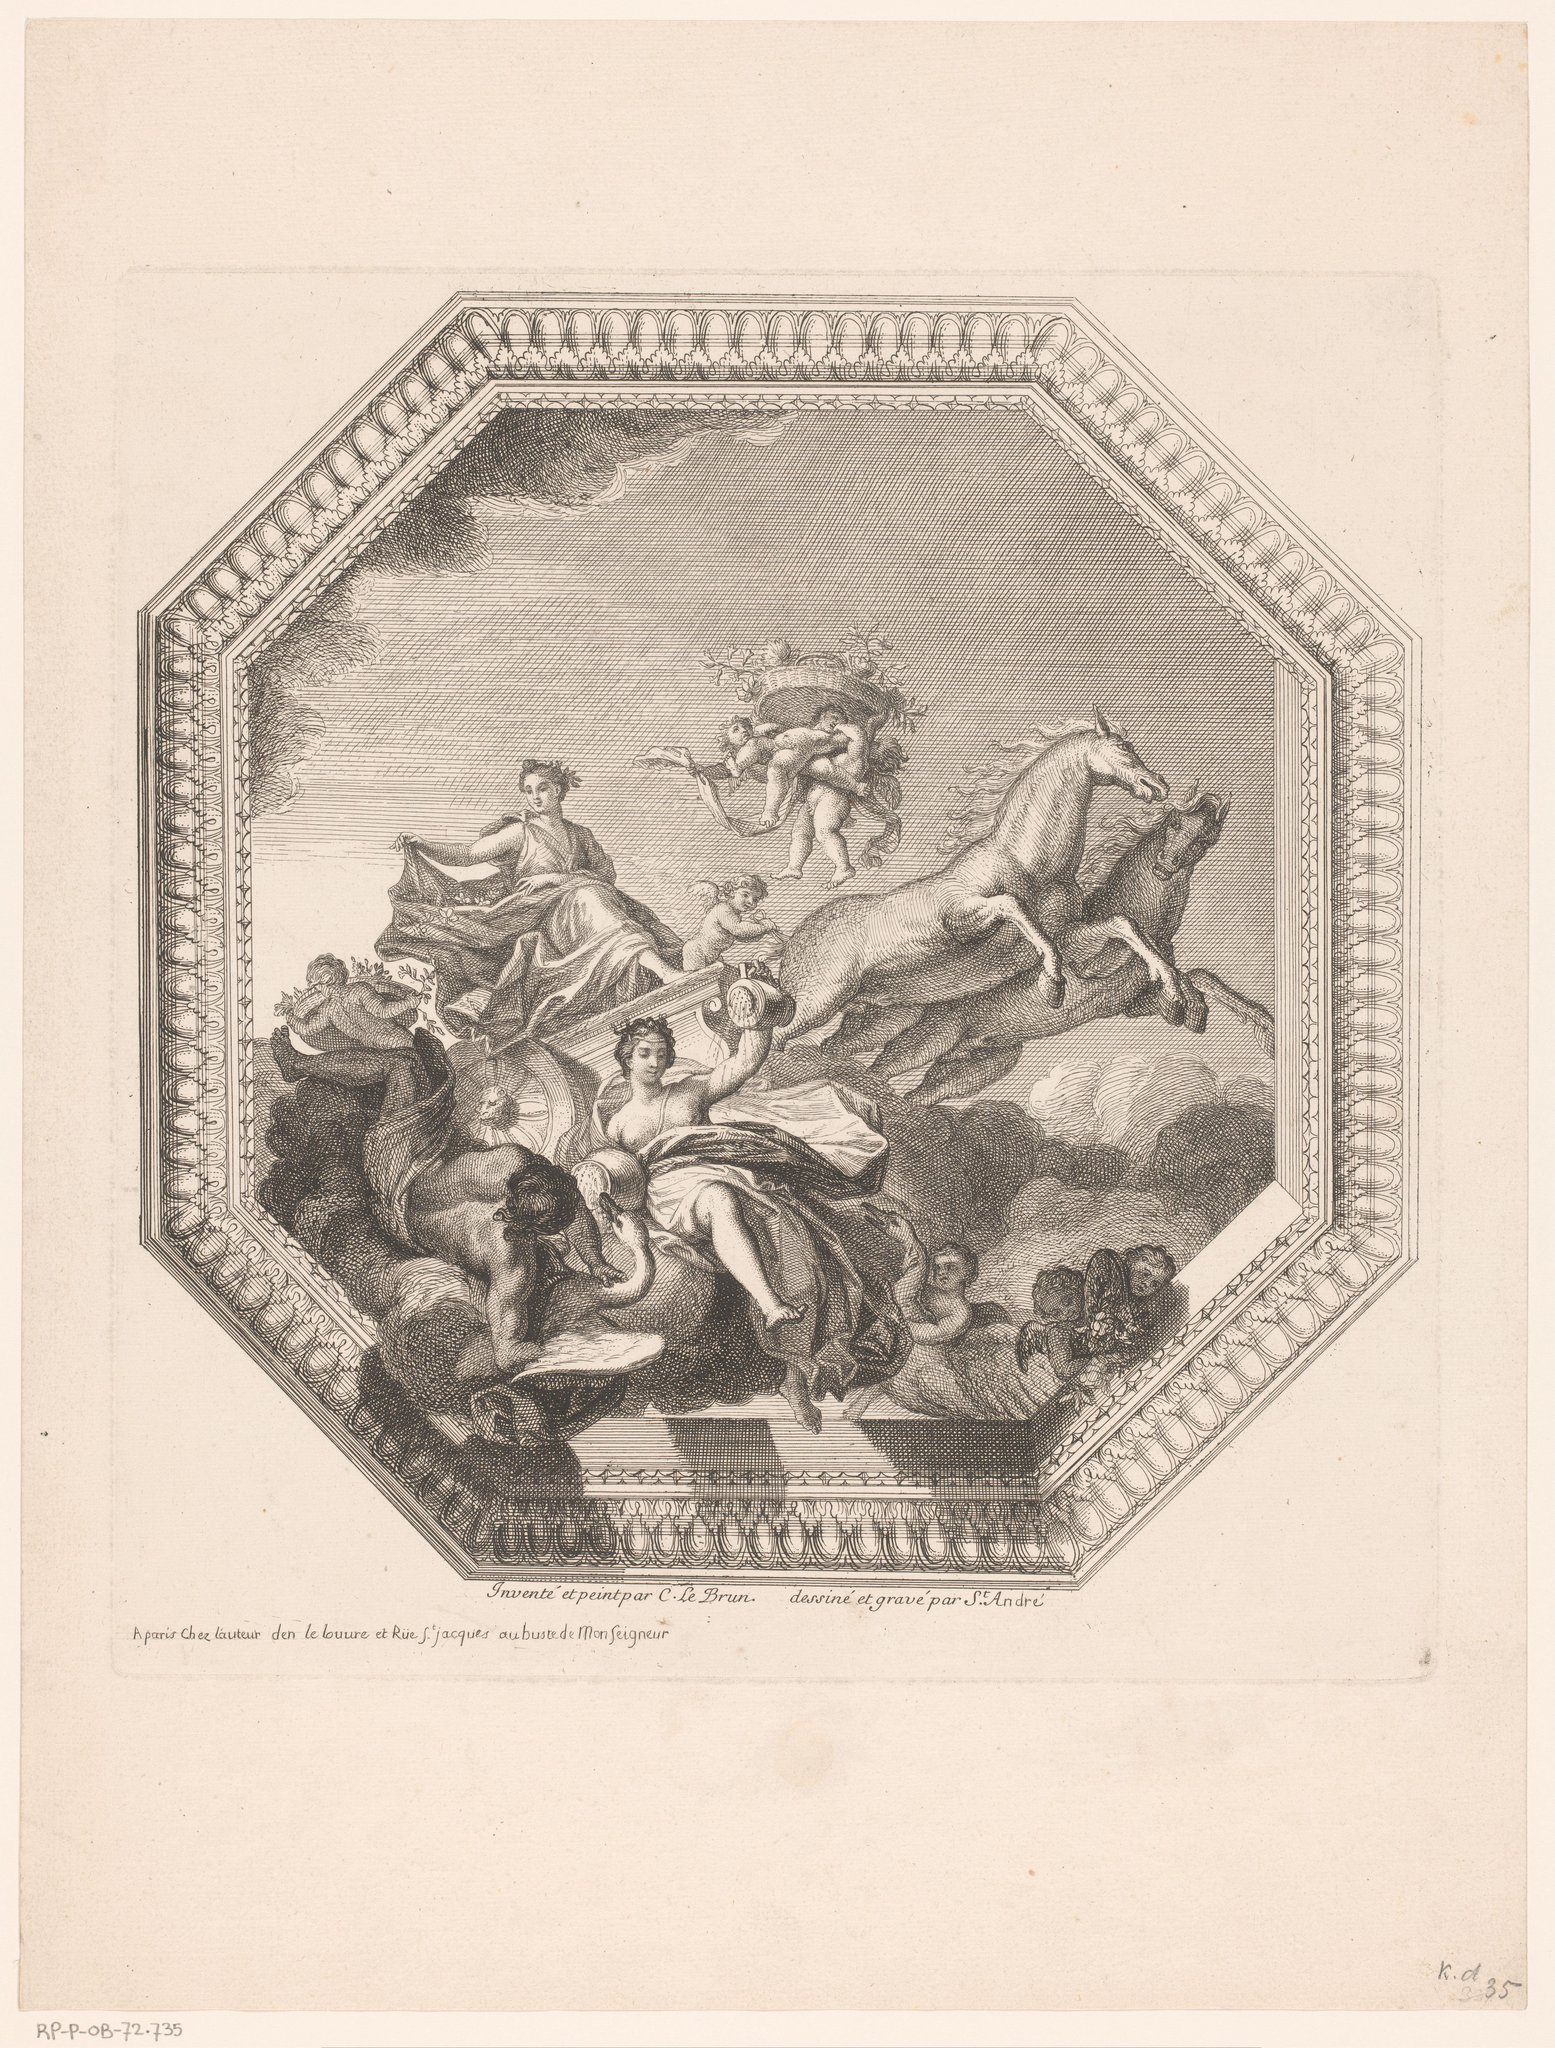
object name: print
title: Venus op een strijdwagen getrokken door paarden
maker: augustin jacques renard de saint-andré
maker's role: print maker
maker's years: 1659-1695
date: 1669-1695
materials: paper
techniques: etching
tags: water-birds: swan, chariot, triumphal car, (story of) venus (aphrodite)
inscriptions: collector's mark: Lugt 240